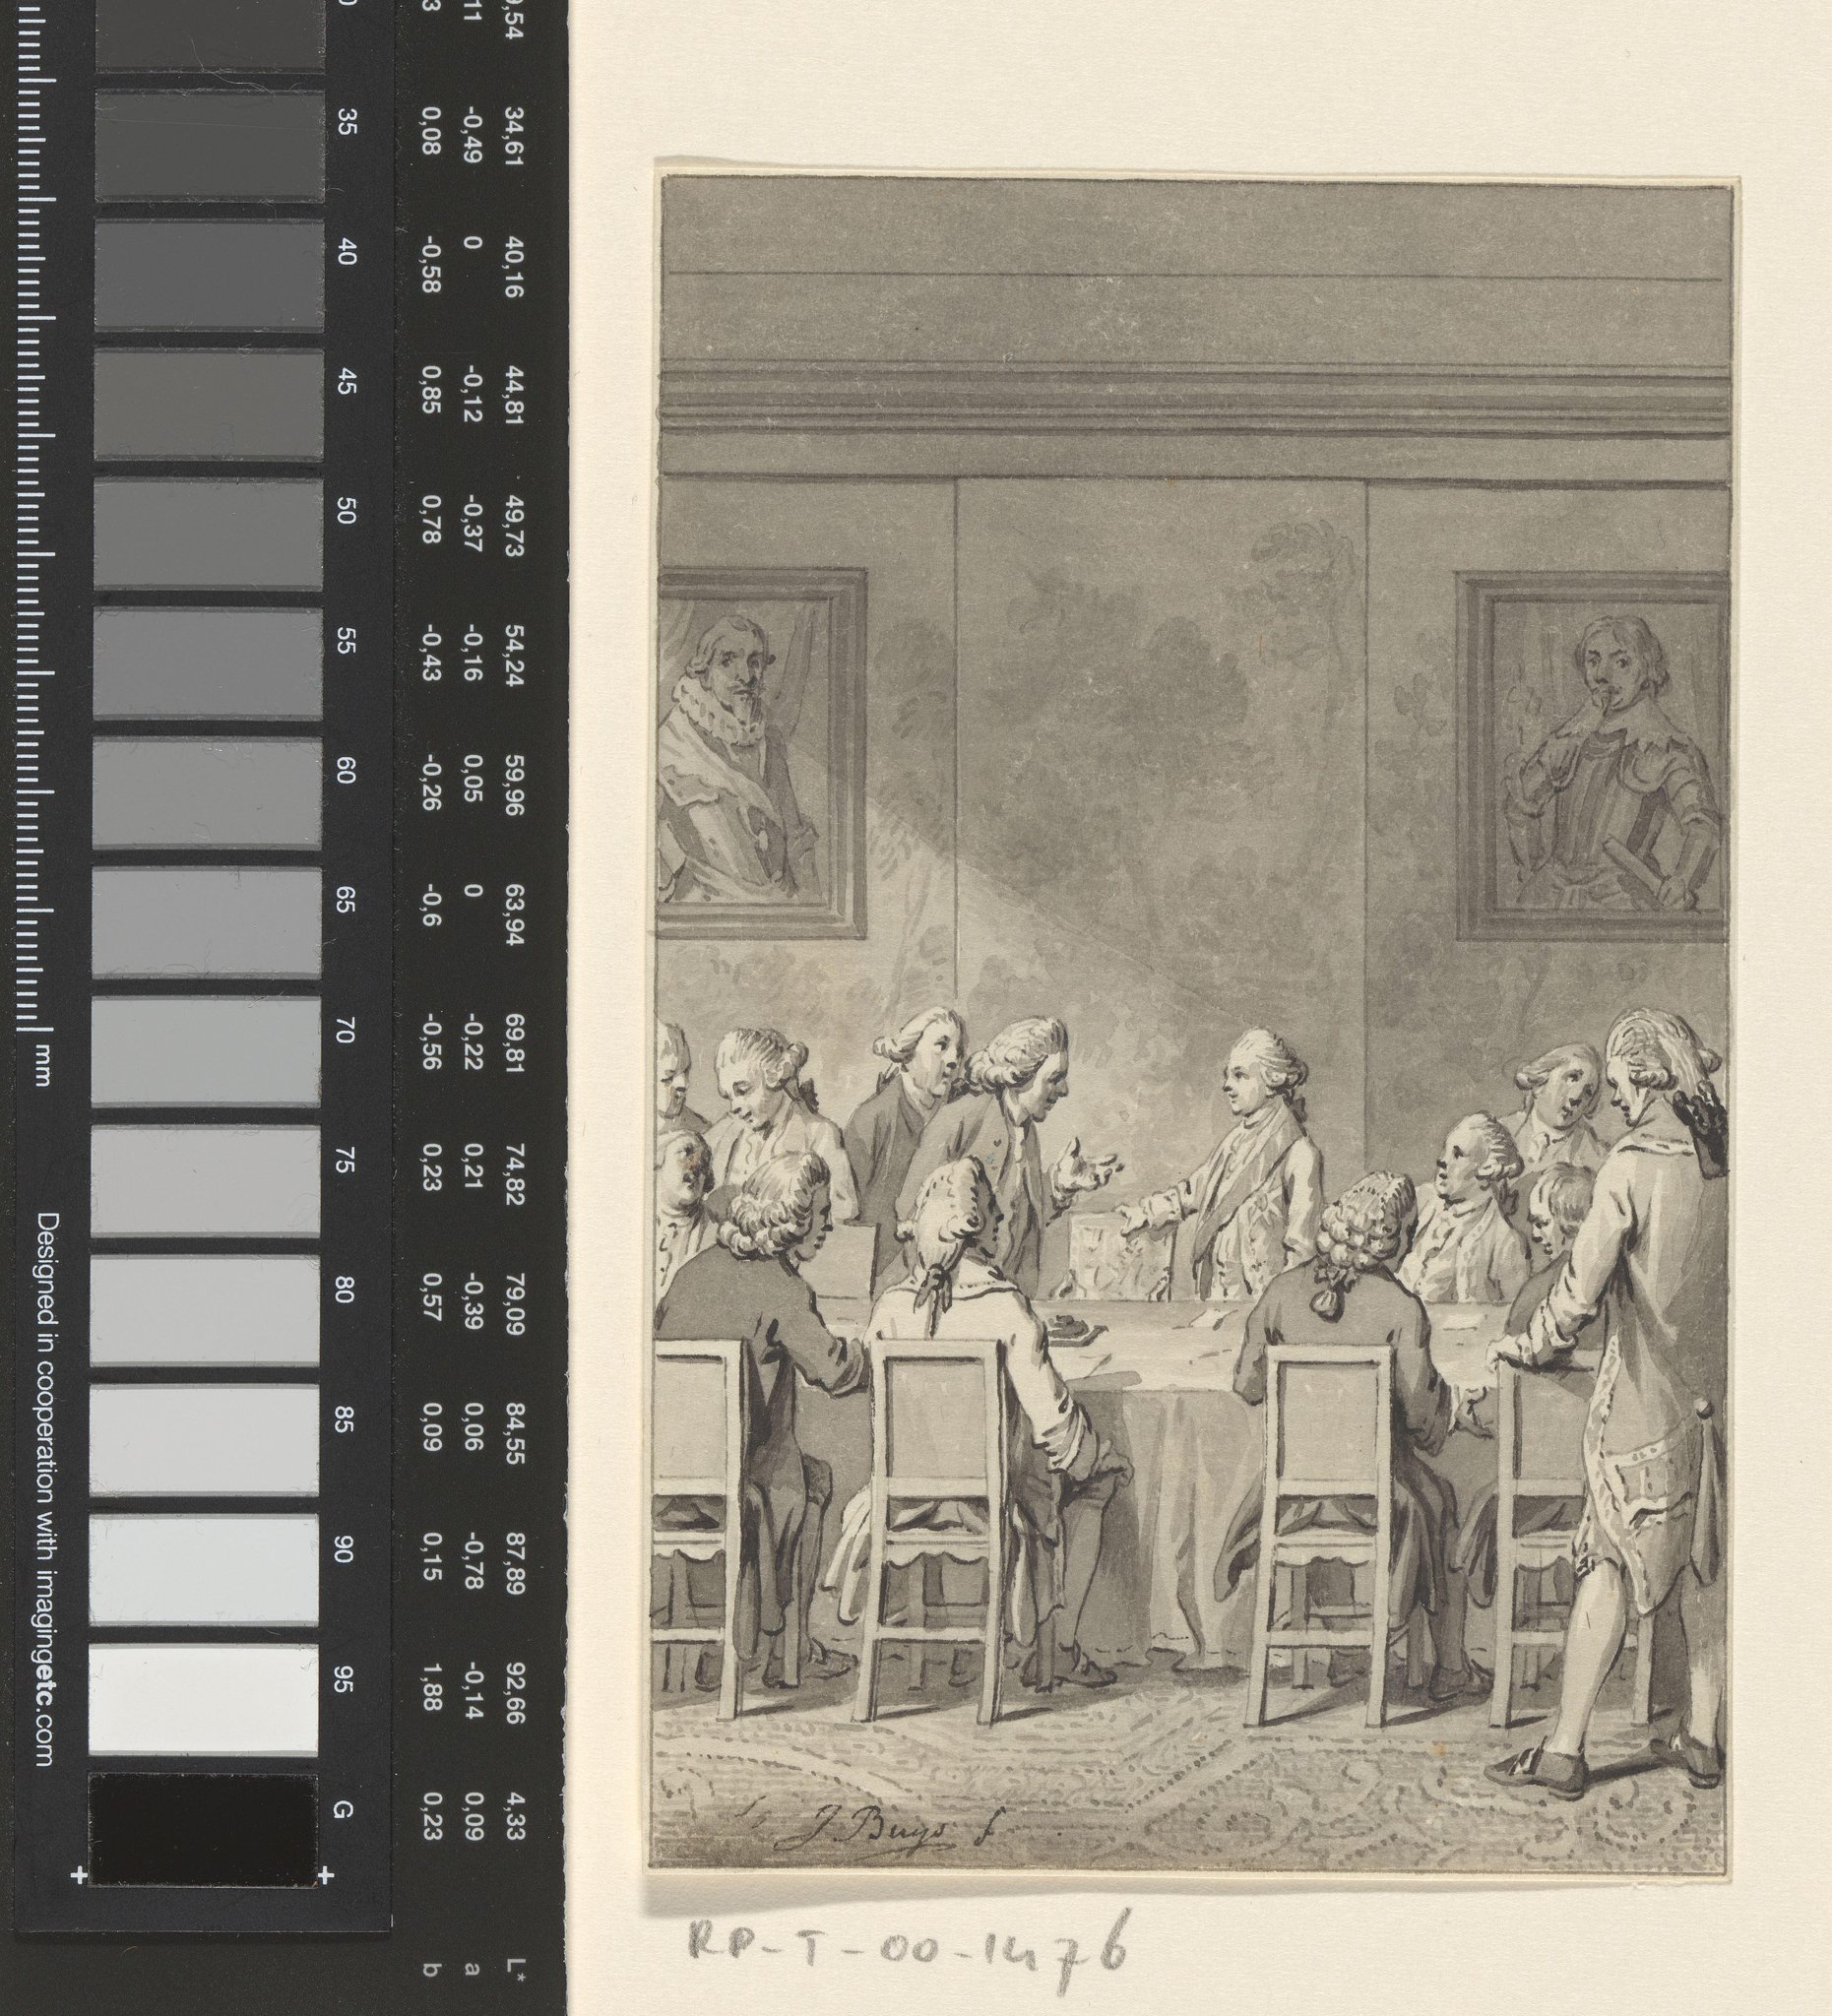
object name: design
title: Willem V neemt voor het eerst zitting in de Raad van State, 1763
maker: jacobus buys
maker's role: draughtsman, print maker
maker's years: 1724-1801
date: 1795-1797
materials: paper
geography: northern netherlands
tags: the hague, william v (prince of orange), historical persons, names of organizations, companies, trade unions, etc., historical events and situations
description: Ontwerptekening voor de prent gebruikt als illustratie in: P.A. Loosjes. Vaderlandsche historie, vervattende de geschiedenissen, der Vereenigde Nederlanden [...]. Drie-en-twintigste deel. Beginnende met den jaare 1759 en eindigende met den jaare 1765, bevattende het tydperk der minderjaarigheid des erfstadhouders Willem den V. Ten onmiddelyken vervolge van Wagenaar's Vaderlandsche historie. Amsterdam: J. Allart, 1797.